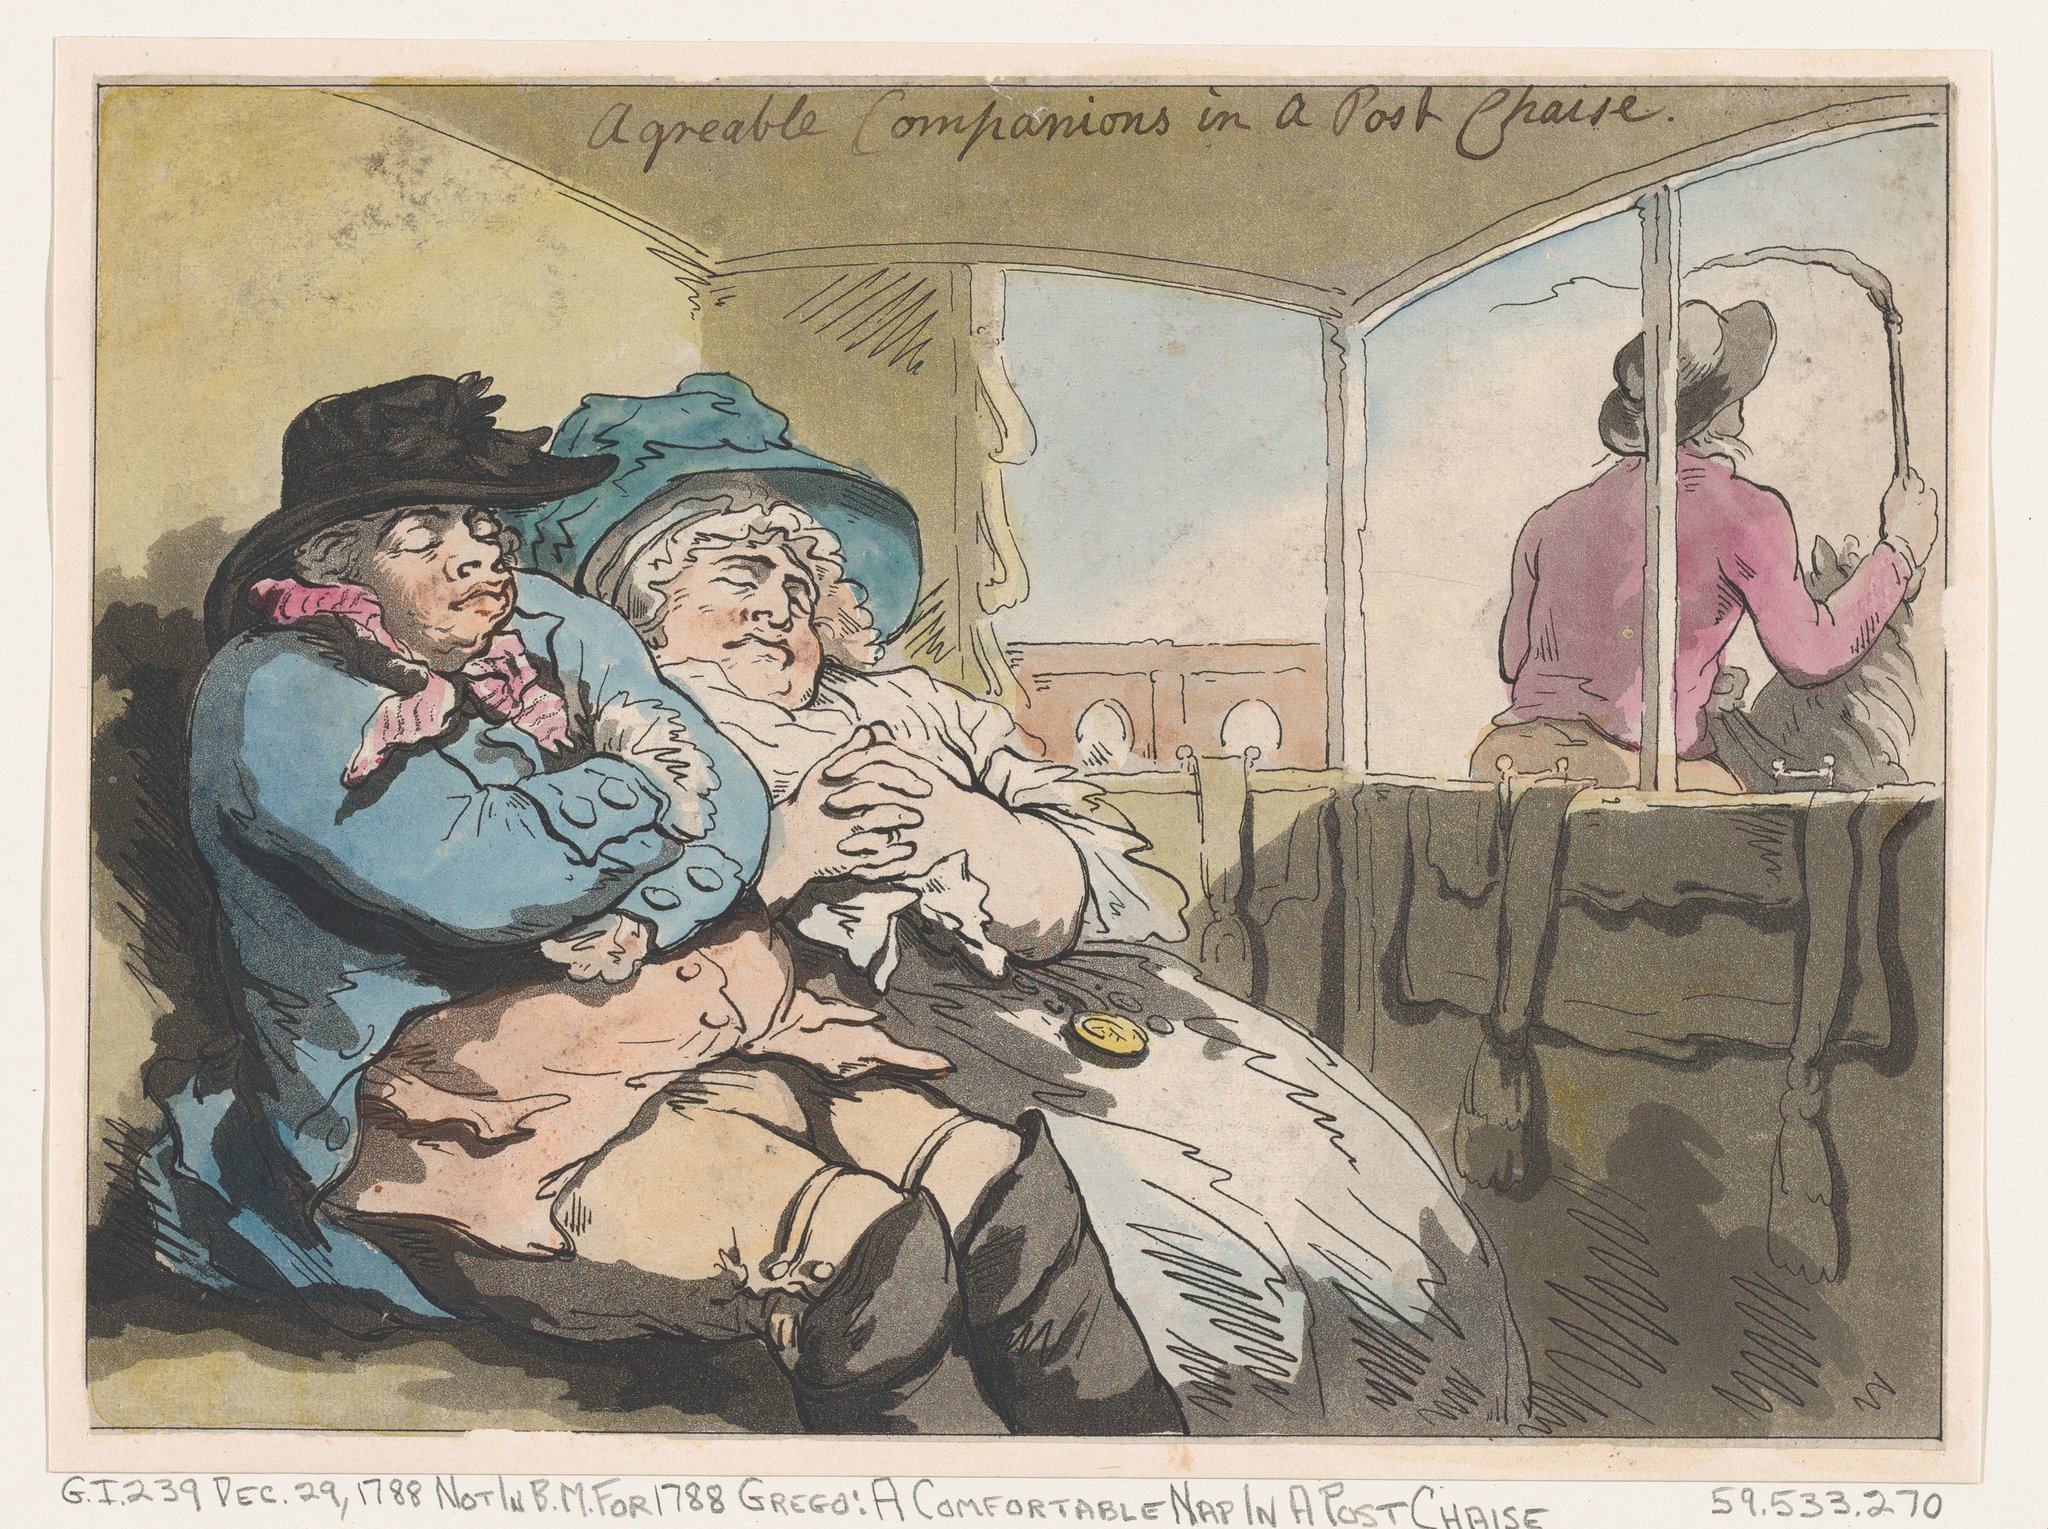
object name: print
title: A Comfortable Nap in a Post Chaise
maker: thomas rowlandson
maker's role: artist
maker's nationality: british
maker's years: 1757-1827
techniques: aquatint, etching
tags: sleeping,men,women,carriages